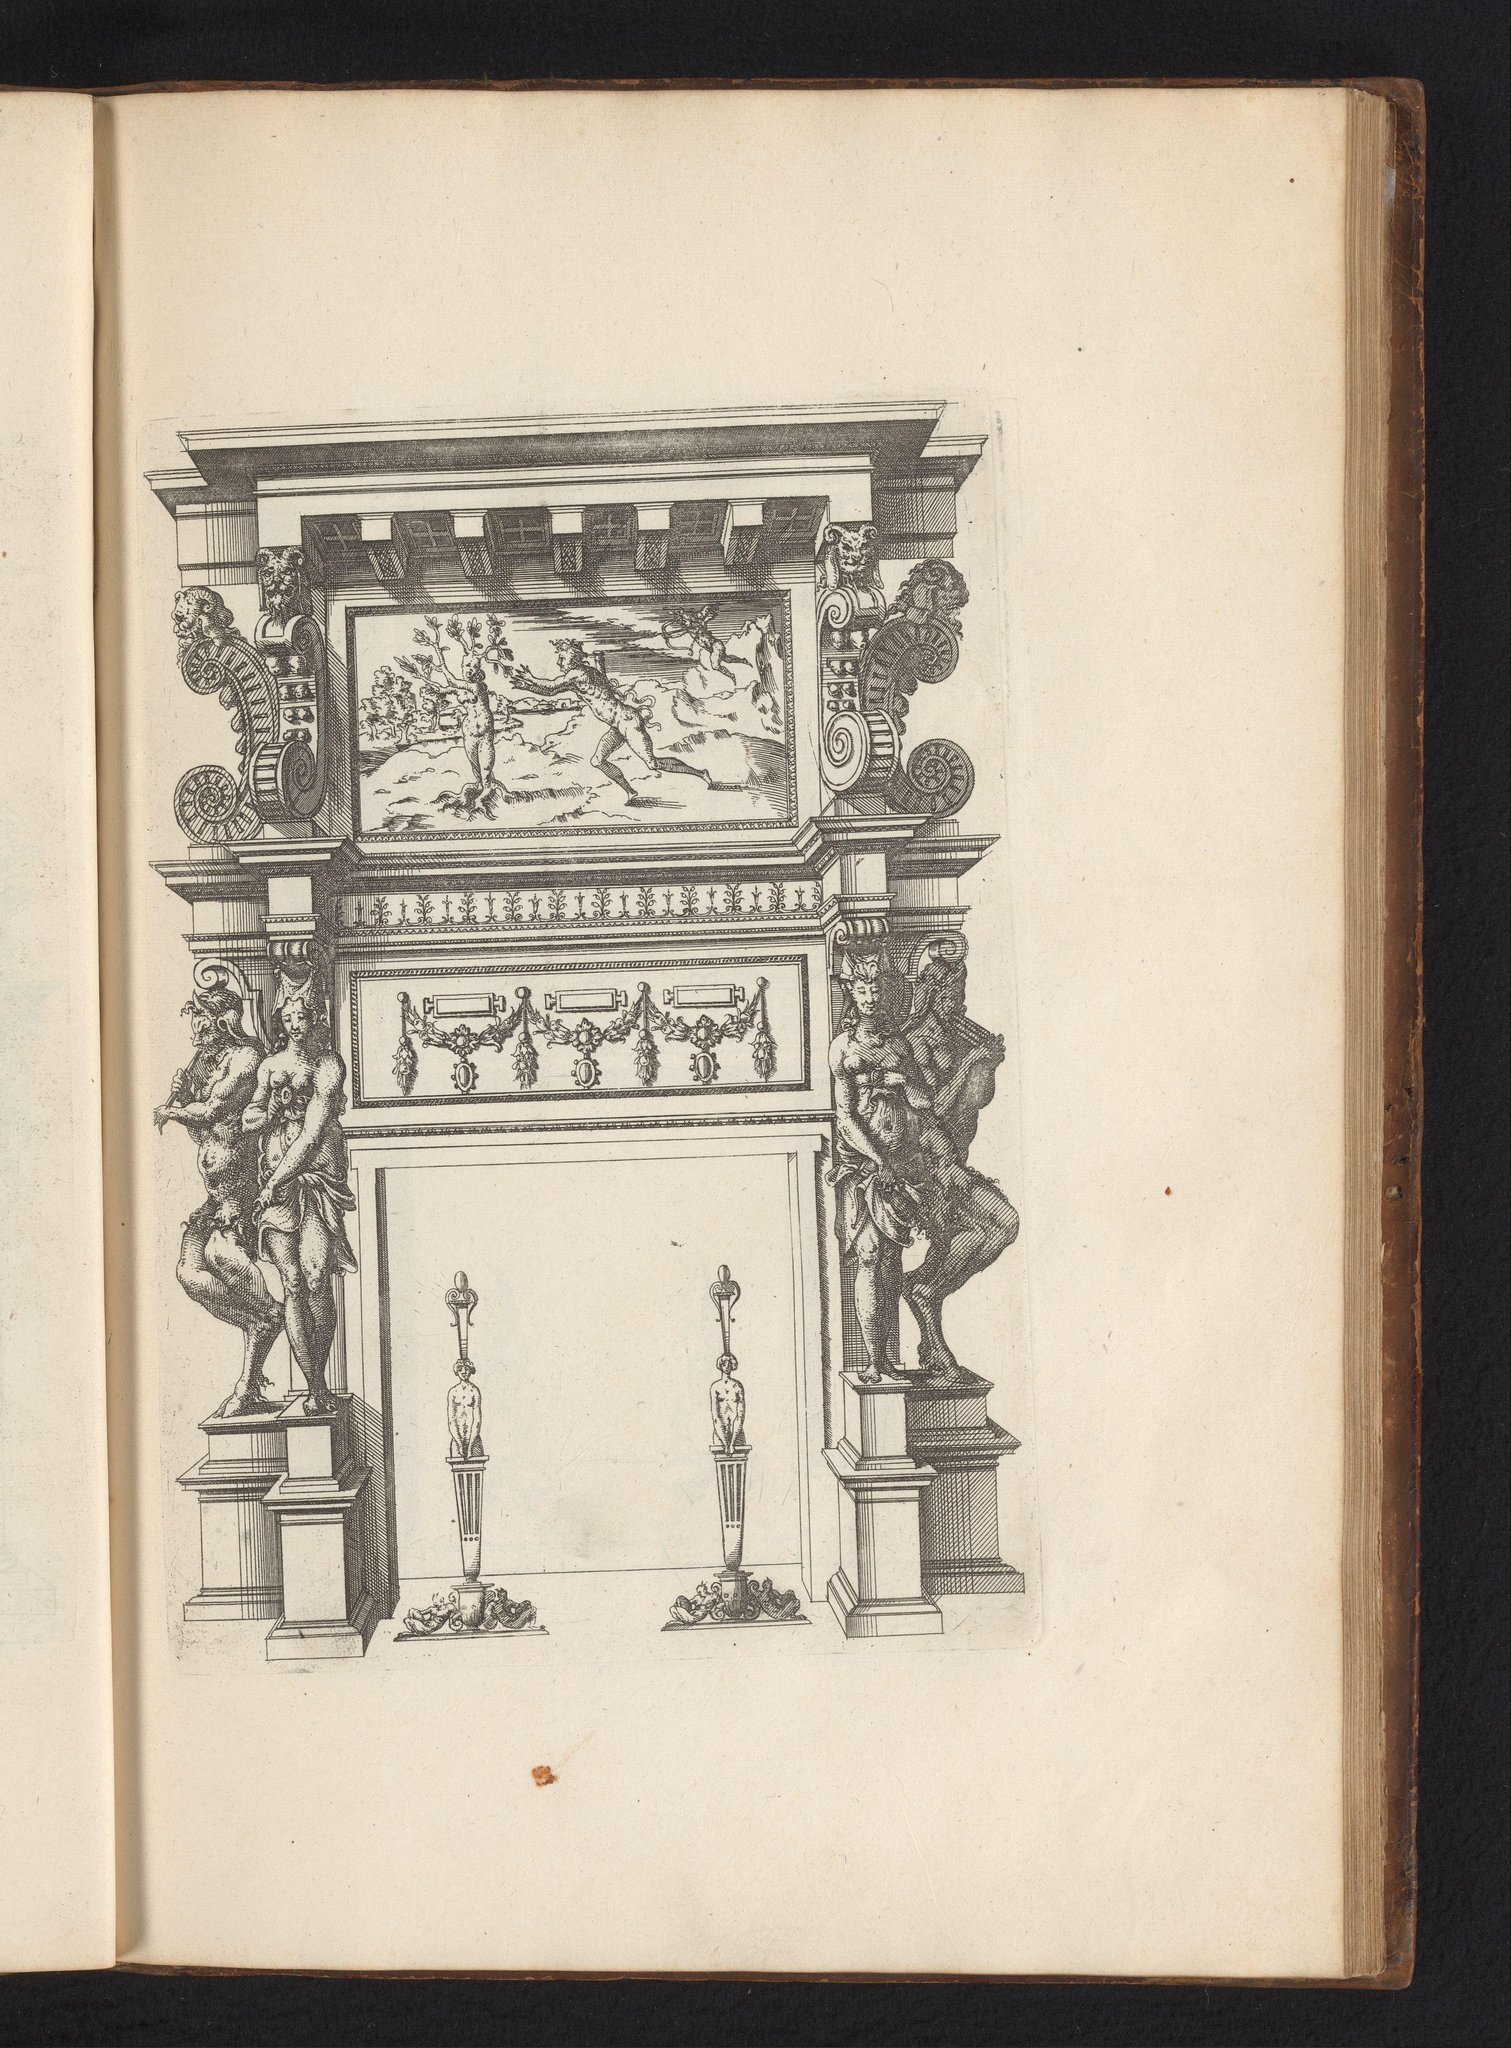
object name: ornament print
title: Schoorsteenmantel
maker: jacques androuet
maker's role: draughtsman, print maker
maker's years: 1515-1584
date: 1561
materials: paper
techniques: etching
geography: paris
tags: caryatids ~ architecture, nymphs (in general); 'ninfe in commune' (ripa), piece of sculpture, reproduction of a piece of sculpture, satyr(s) (in general), architectural design or model, chimney-piece, mantelpiece, daphne changed into a laurel-tree: while fleeing from apollo, daphne is changed into a laurel-tree by her father peneus (ovid, metamorphoses i 548)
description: Schoorsteenmantel met aan weerszijden beelden van saters en kariatiden op de schouw een voorstelling van Apollo en Daphne. Onderdeel van 'Seconde livre d'architectvre' (1561): 64 etsen met geornamenteerde architectuuronderdelen.